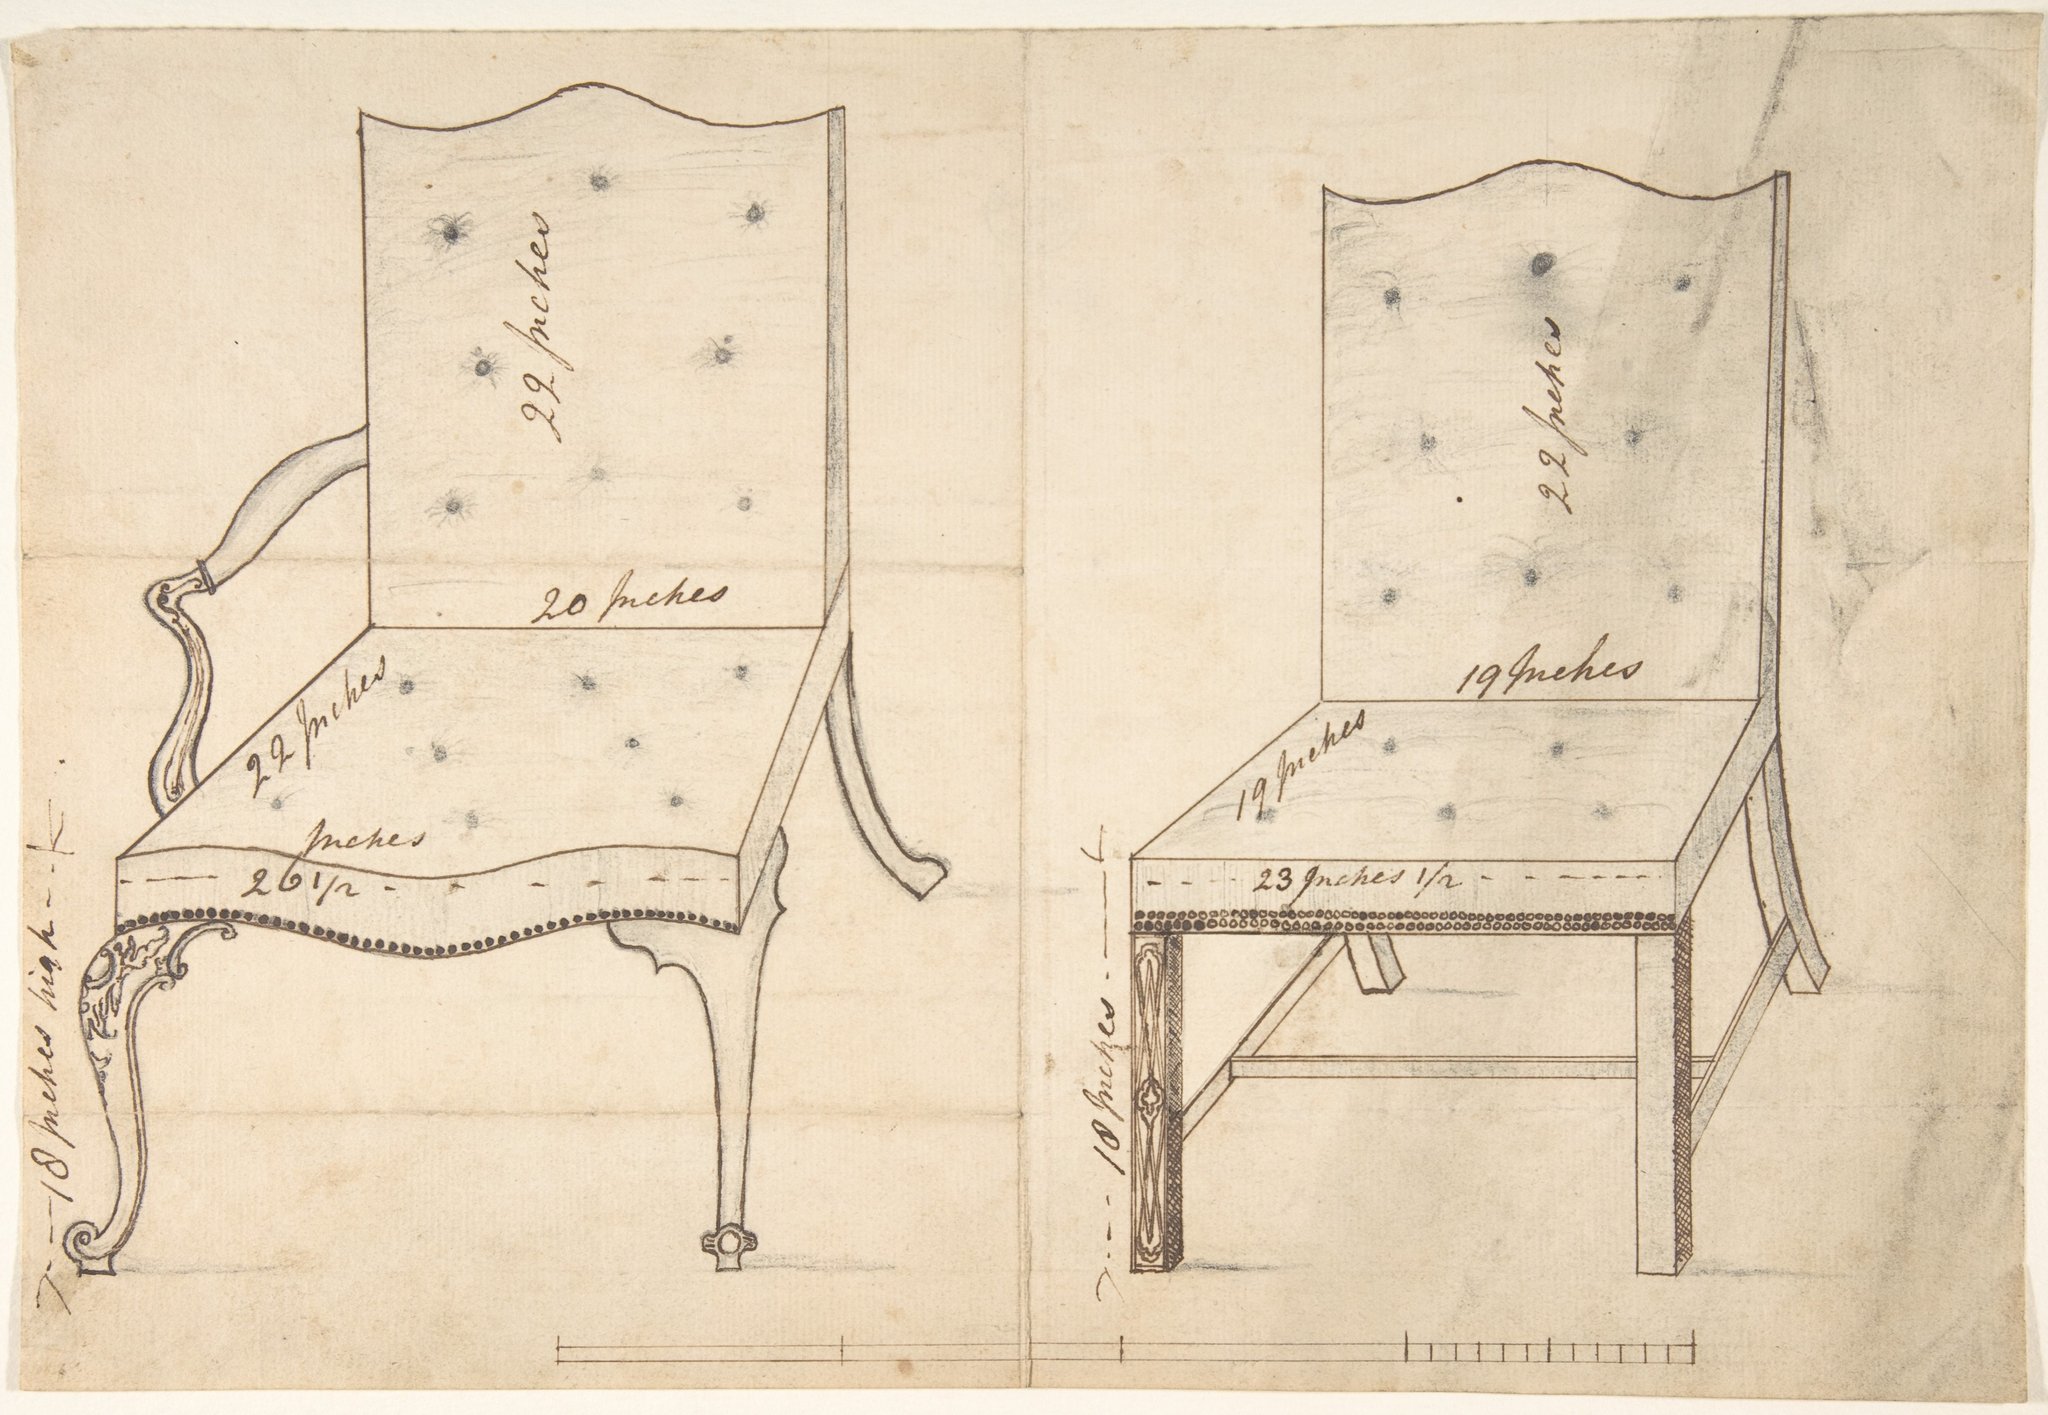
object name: drawing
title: Designs for an Armchair and Side Chair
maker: anonymous, british, 18th century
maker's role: artist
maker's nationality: british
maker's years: 1700-1800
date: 1701-1800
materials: graphite, ink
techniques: pen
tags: chairs